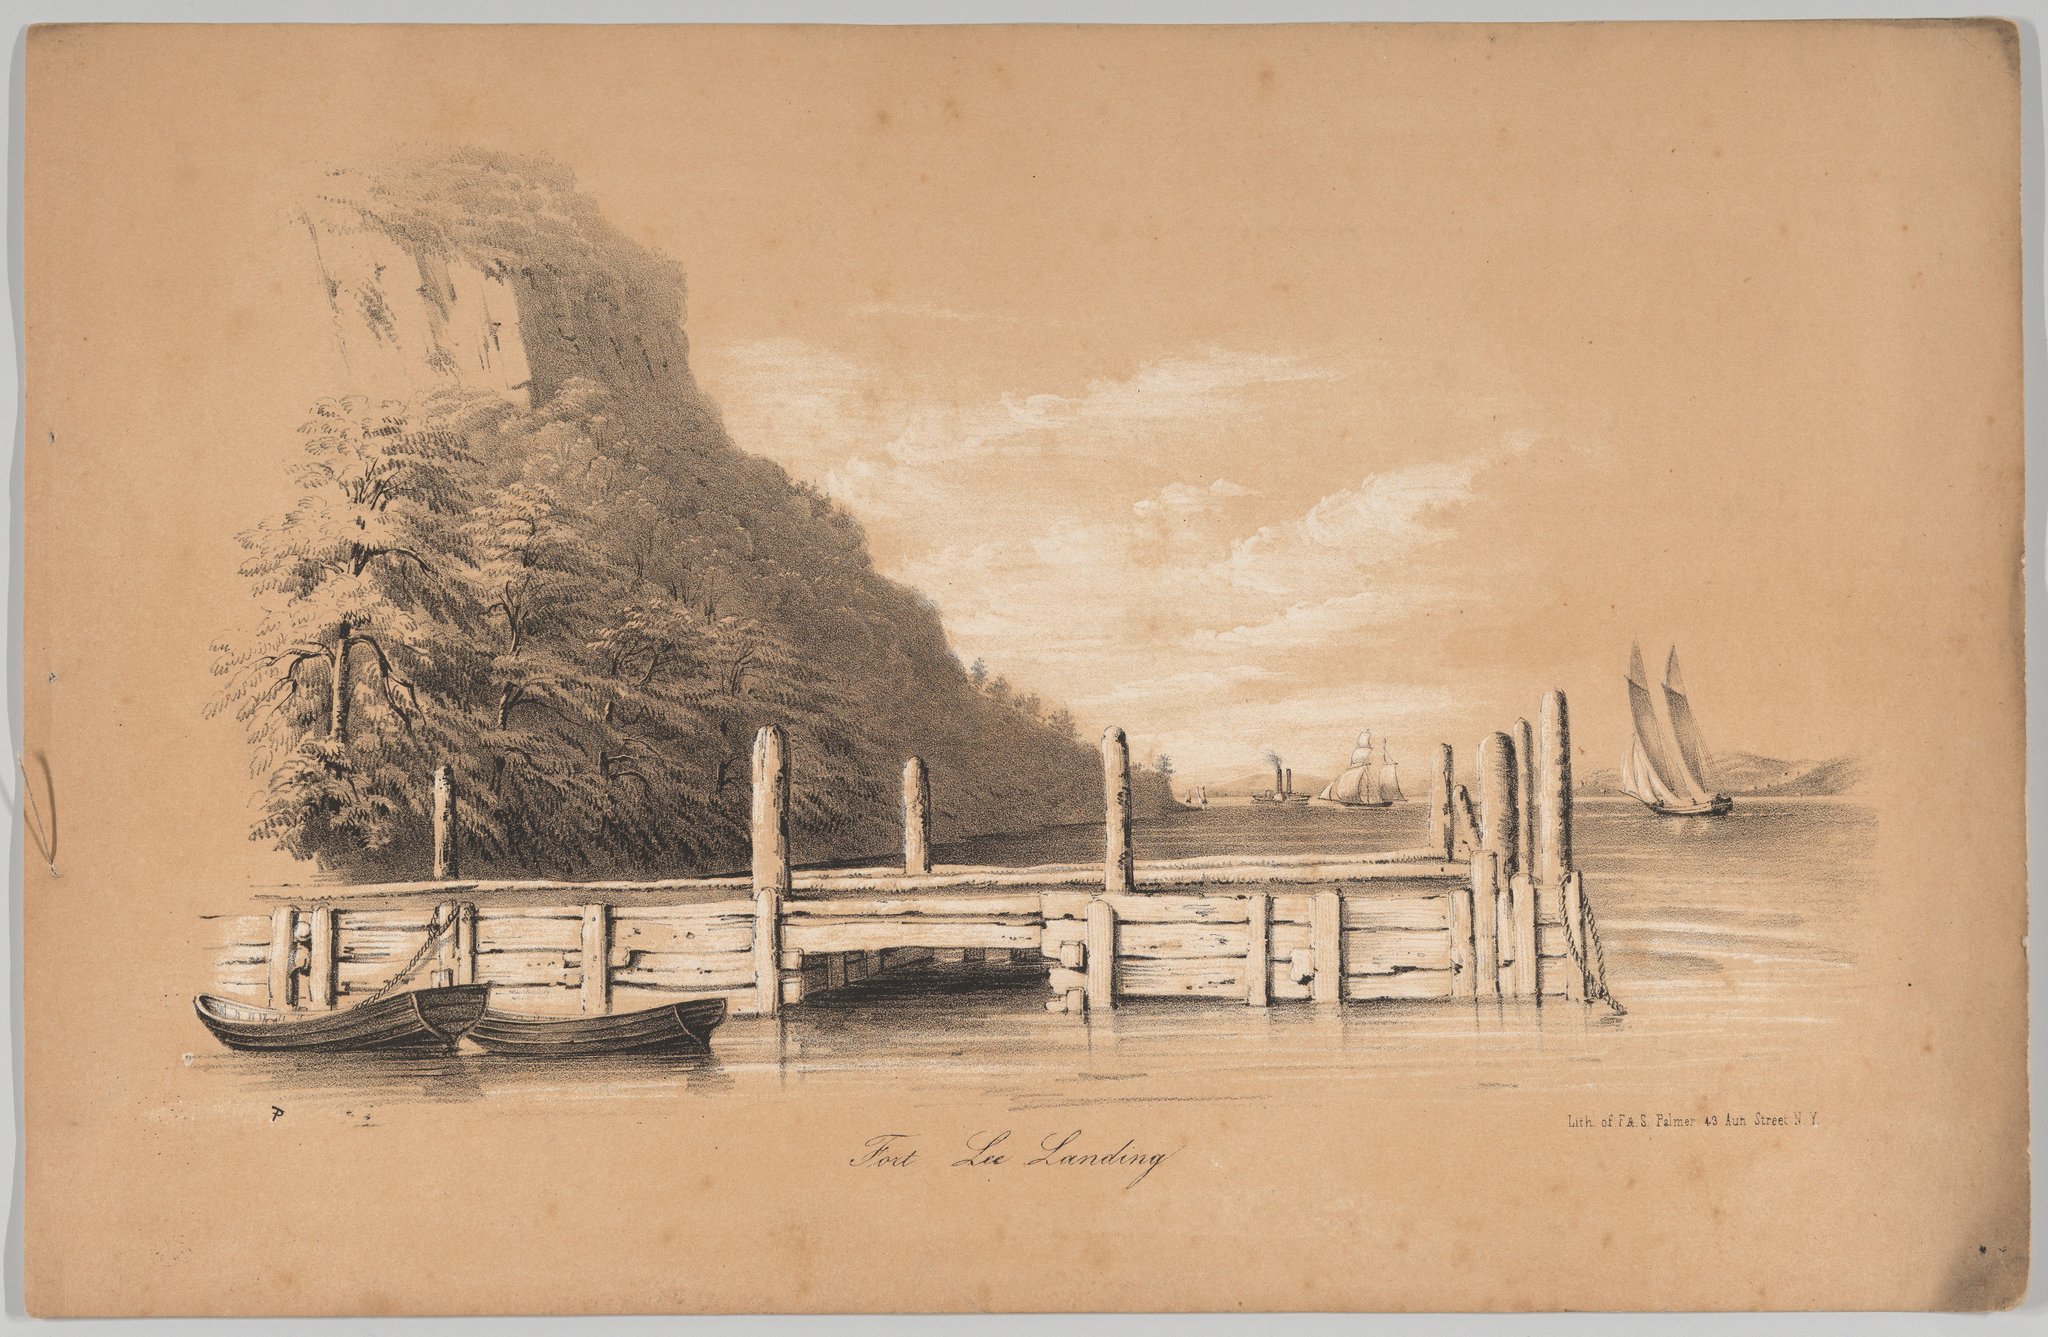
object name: book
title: Fort Lee Landing, in: The New York Drawing Book, Containing a Series of Original Designs and Sketches of American Scenery, No. 2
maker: frances flora bond palmer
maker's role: artist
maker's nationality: american, born england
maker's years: 1812-1876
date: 1847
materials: ink, paper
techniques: lithograph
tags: docks,boats